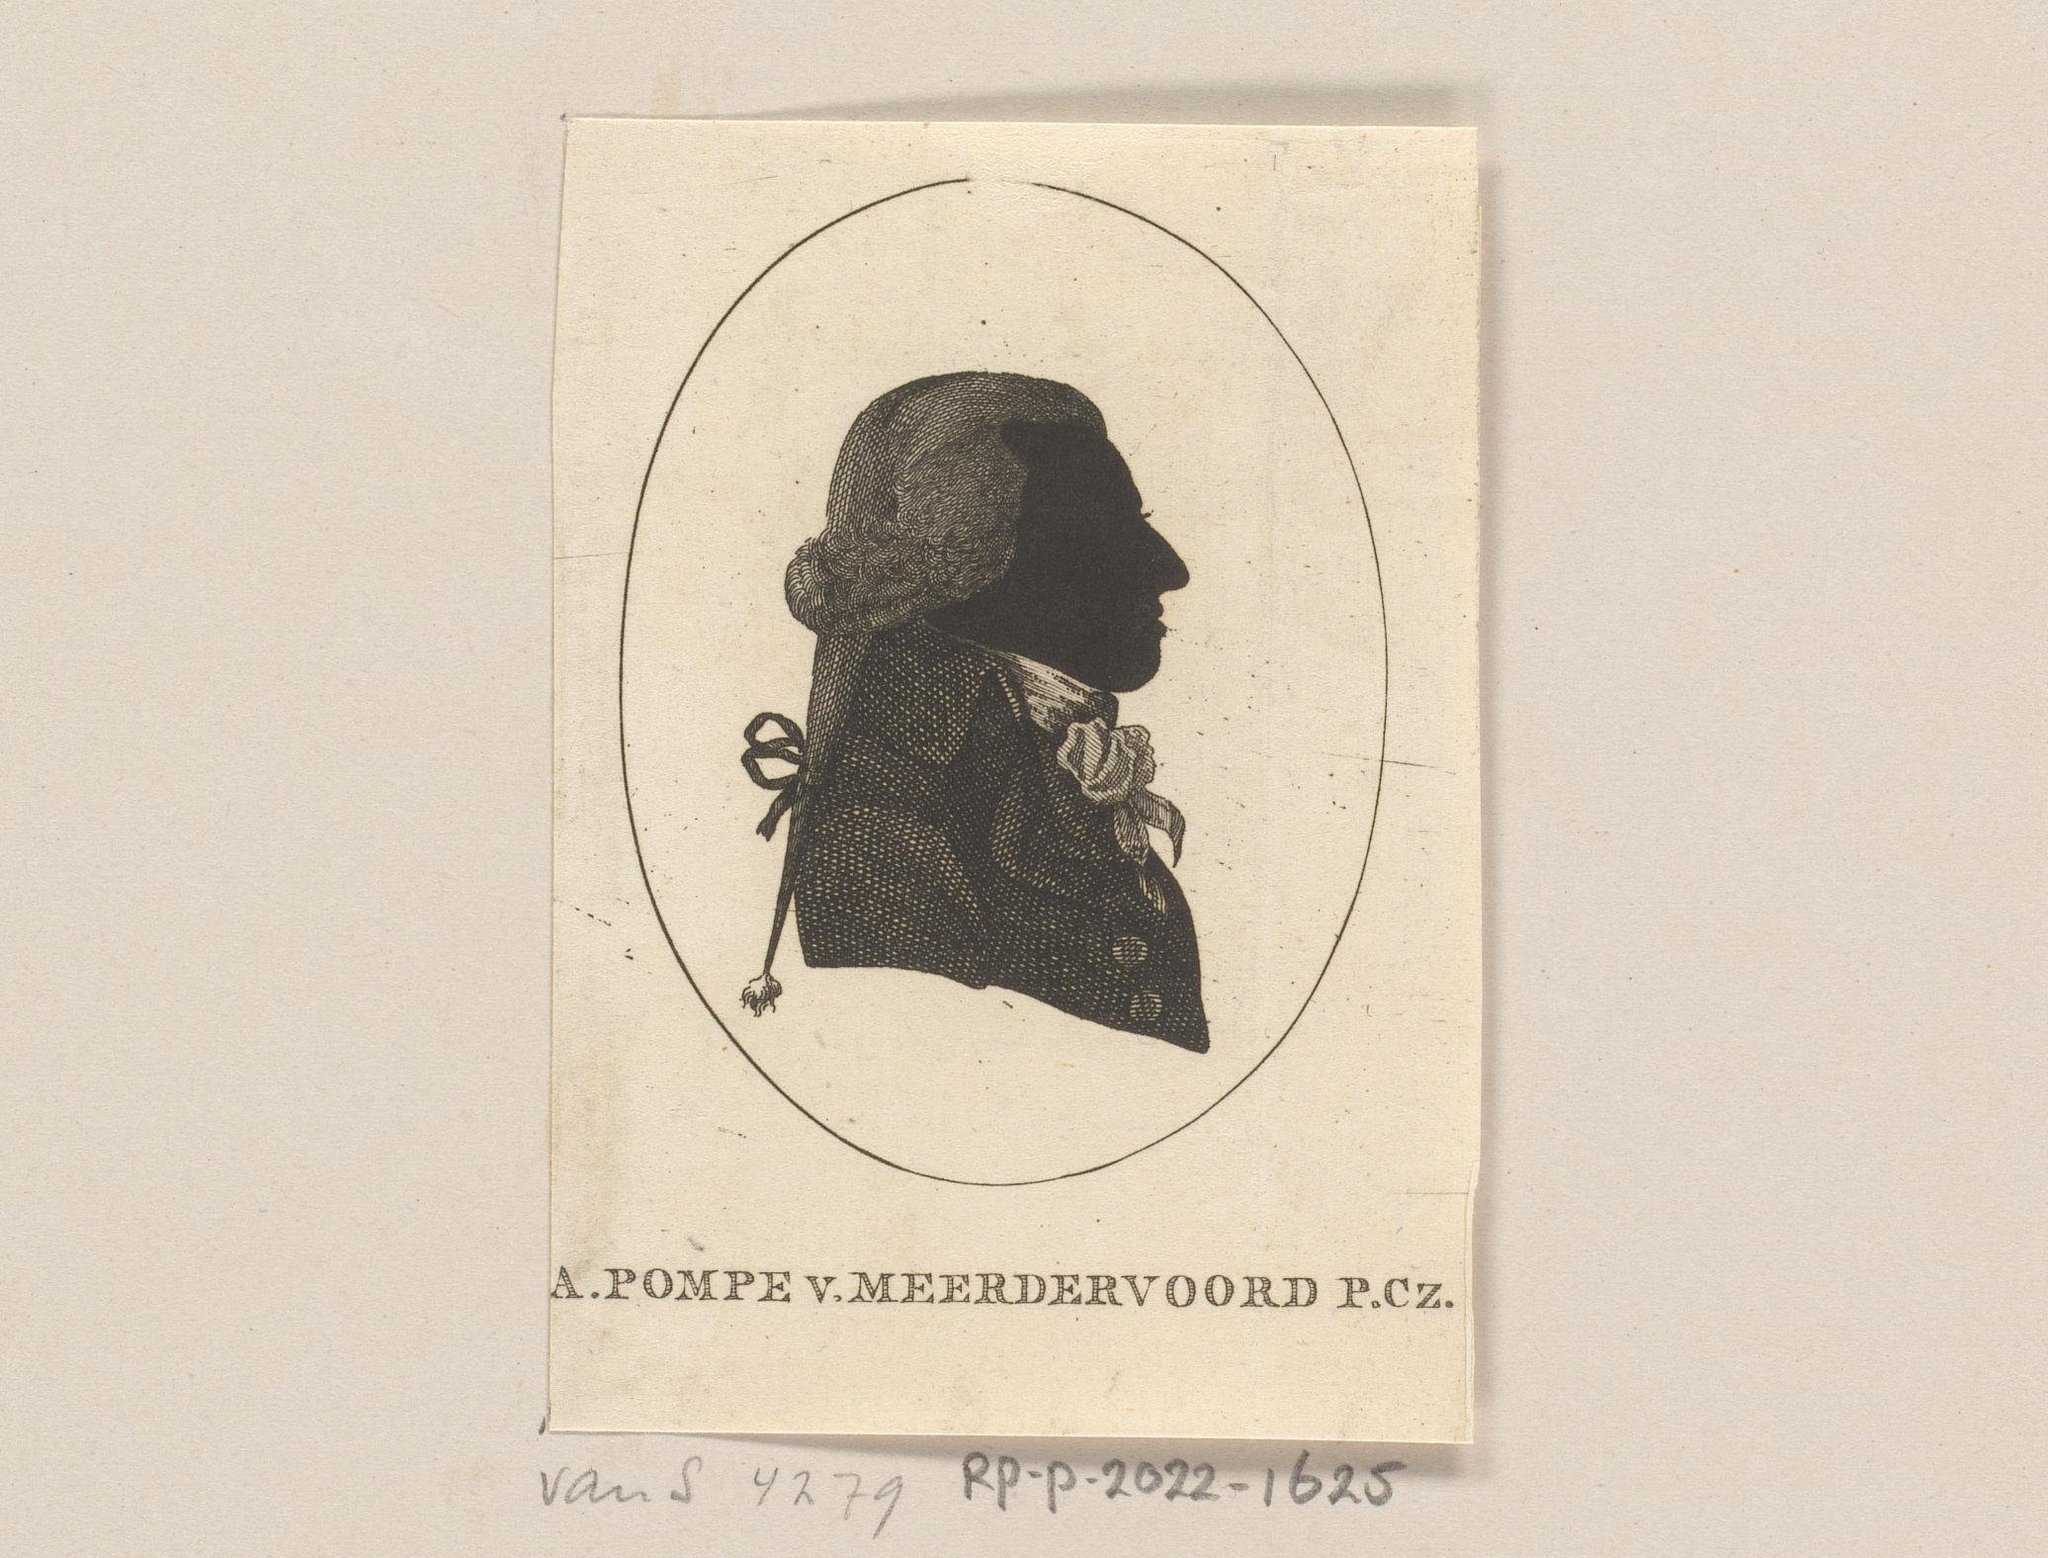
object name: print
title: Portret van Abraham Pompe van Meerdervoort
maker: Anonymous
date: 1794-1850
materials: paper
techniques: etching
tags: historical persons, politician, e.g. party leader